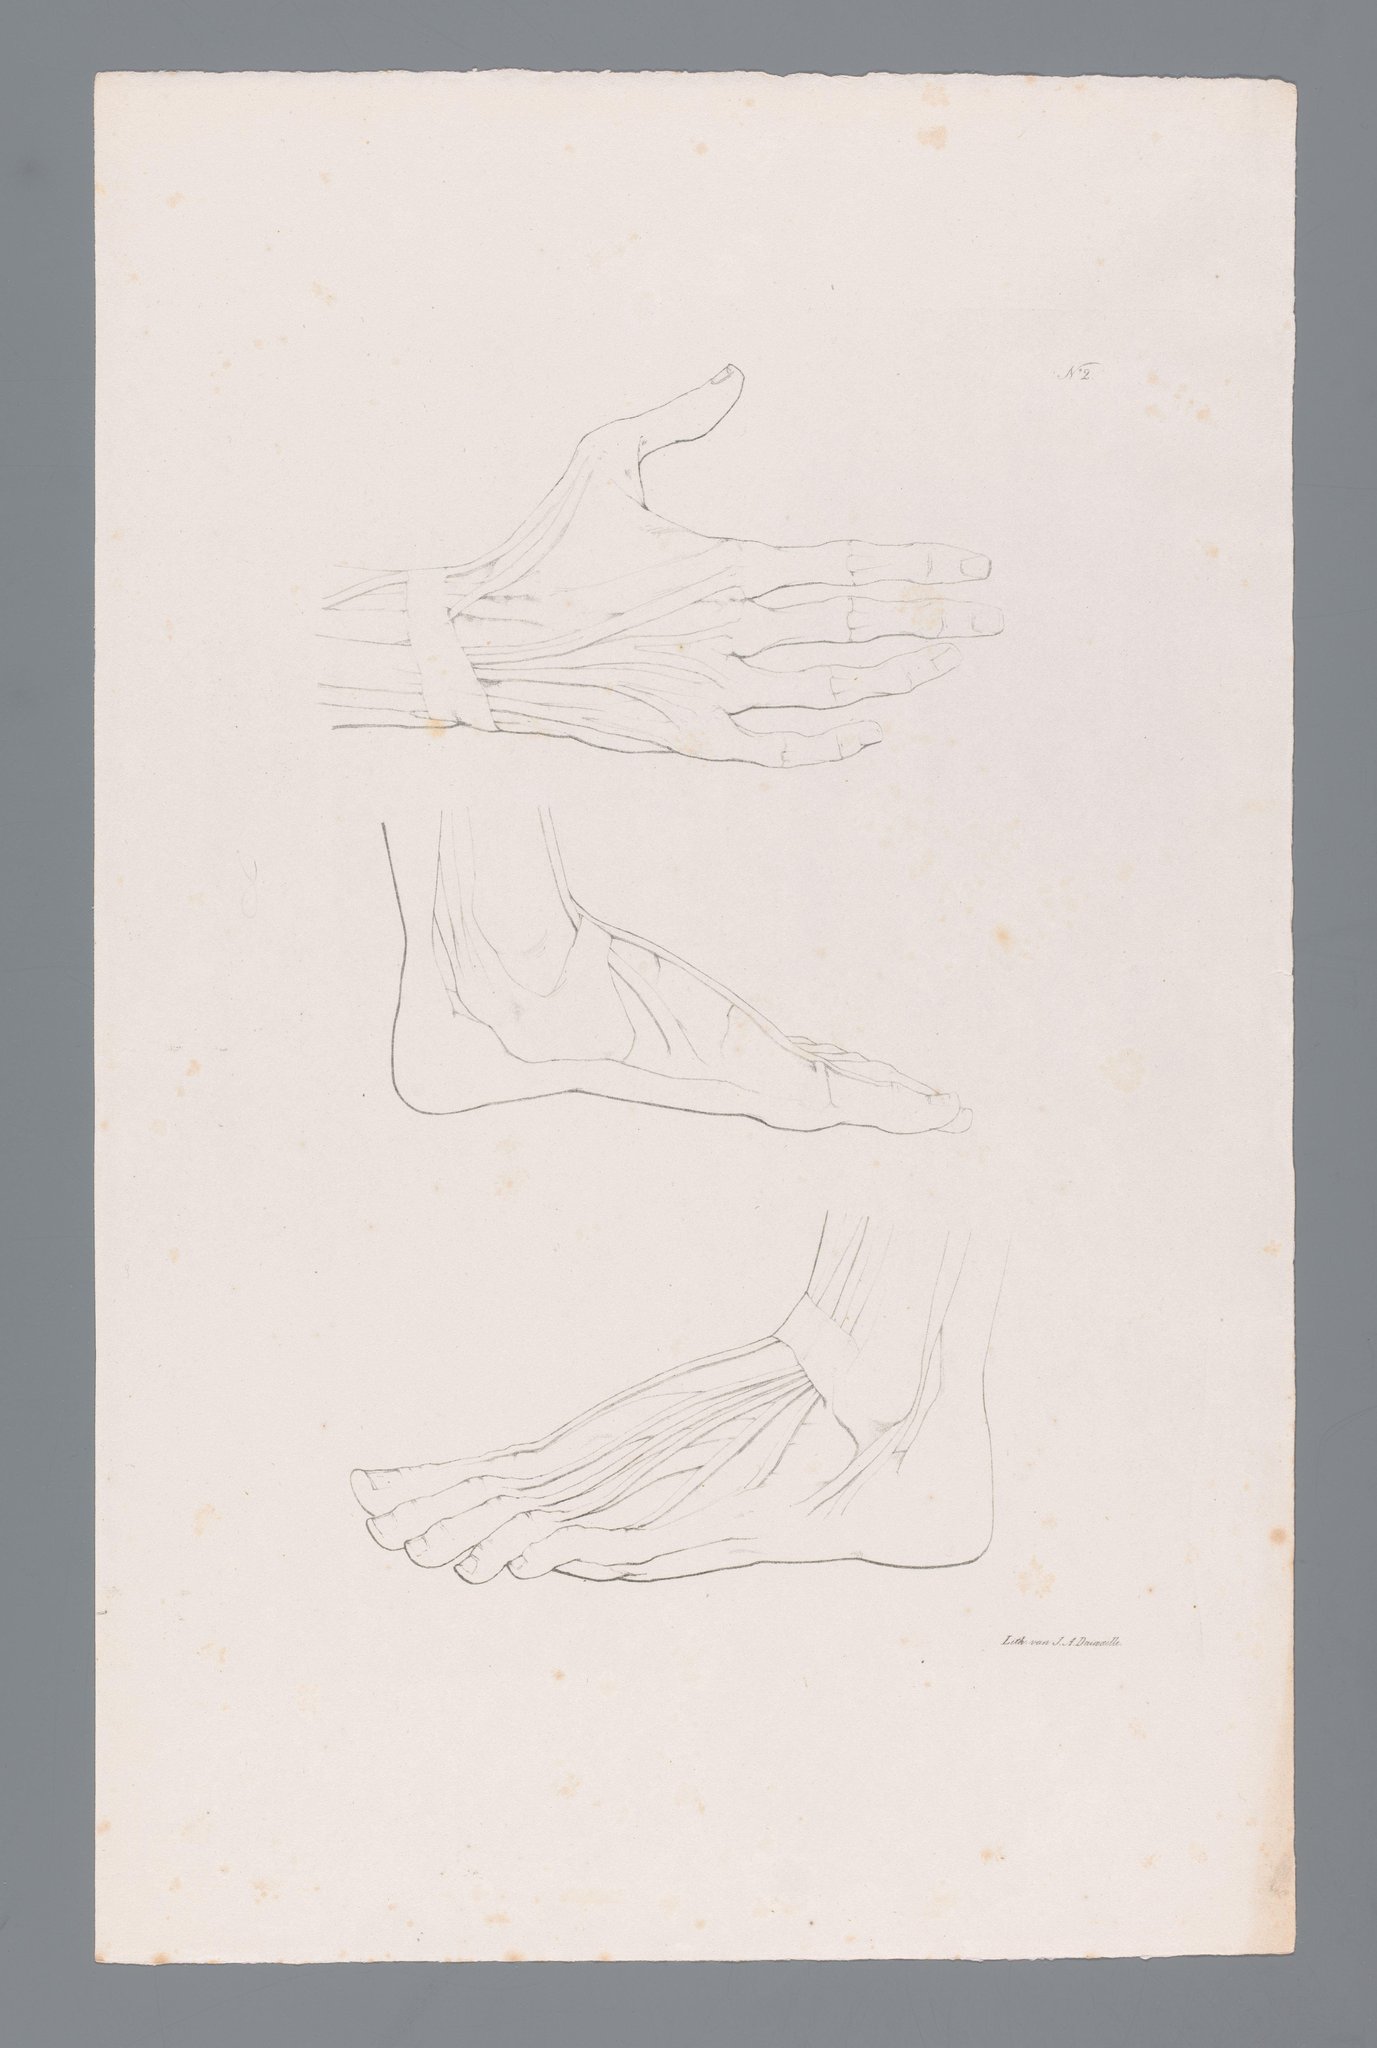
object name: print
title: Drie anatomieën van een hand en voet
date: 1828-1830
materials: paper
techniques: lithograph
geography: amsterdam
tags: hand, foot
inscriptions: collector's mark: Lugt 2228, watermark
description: Onderdeel van een omslag met in totaal achttien anatomische voorstellingen.